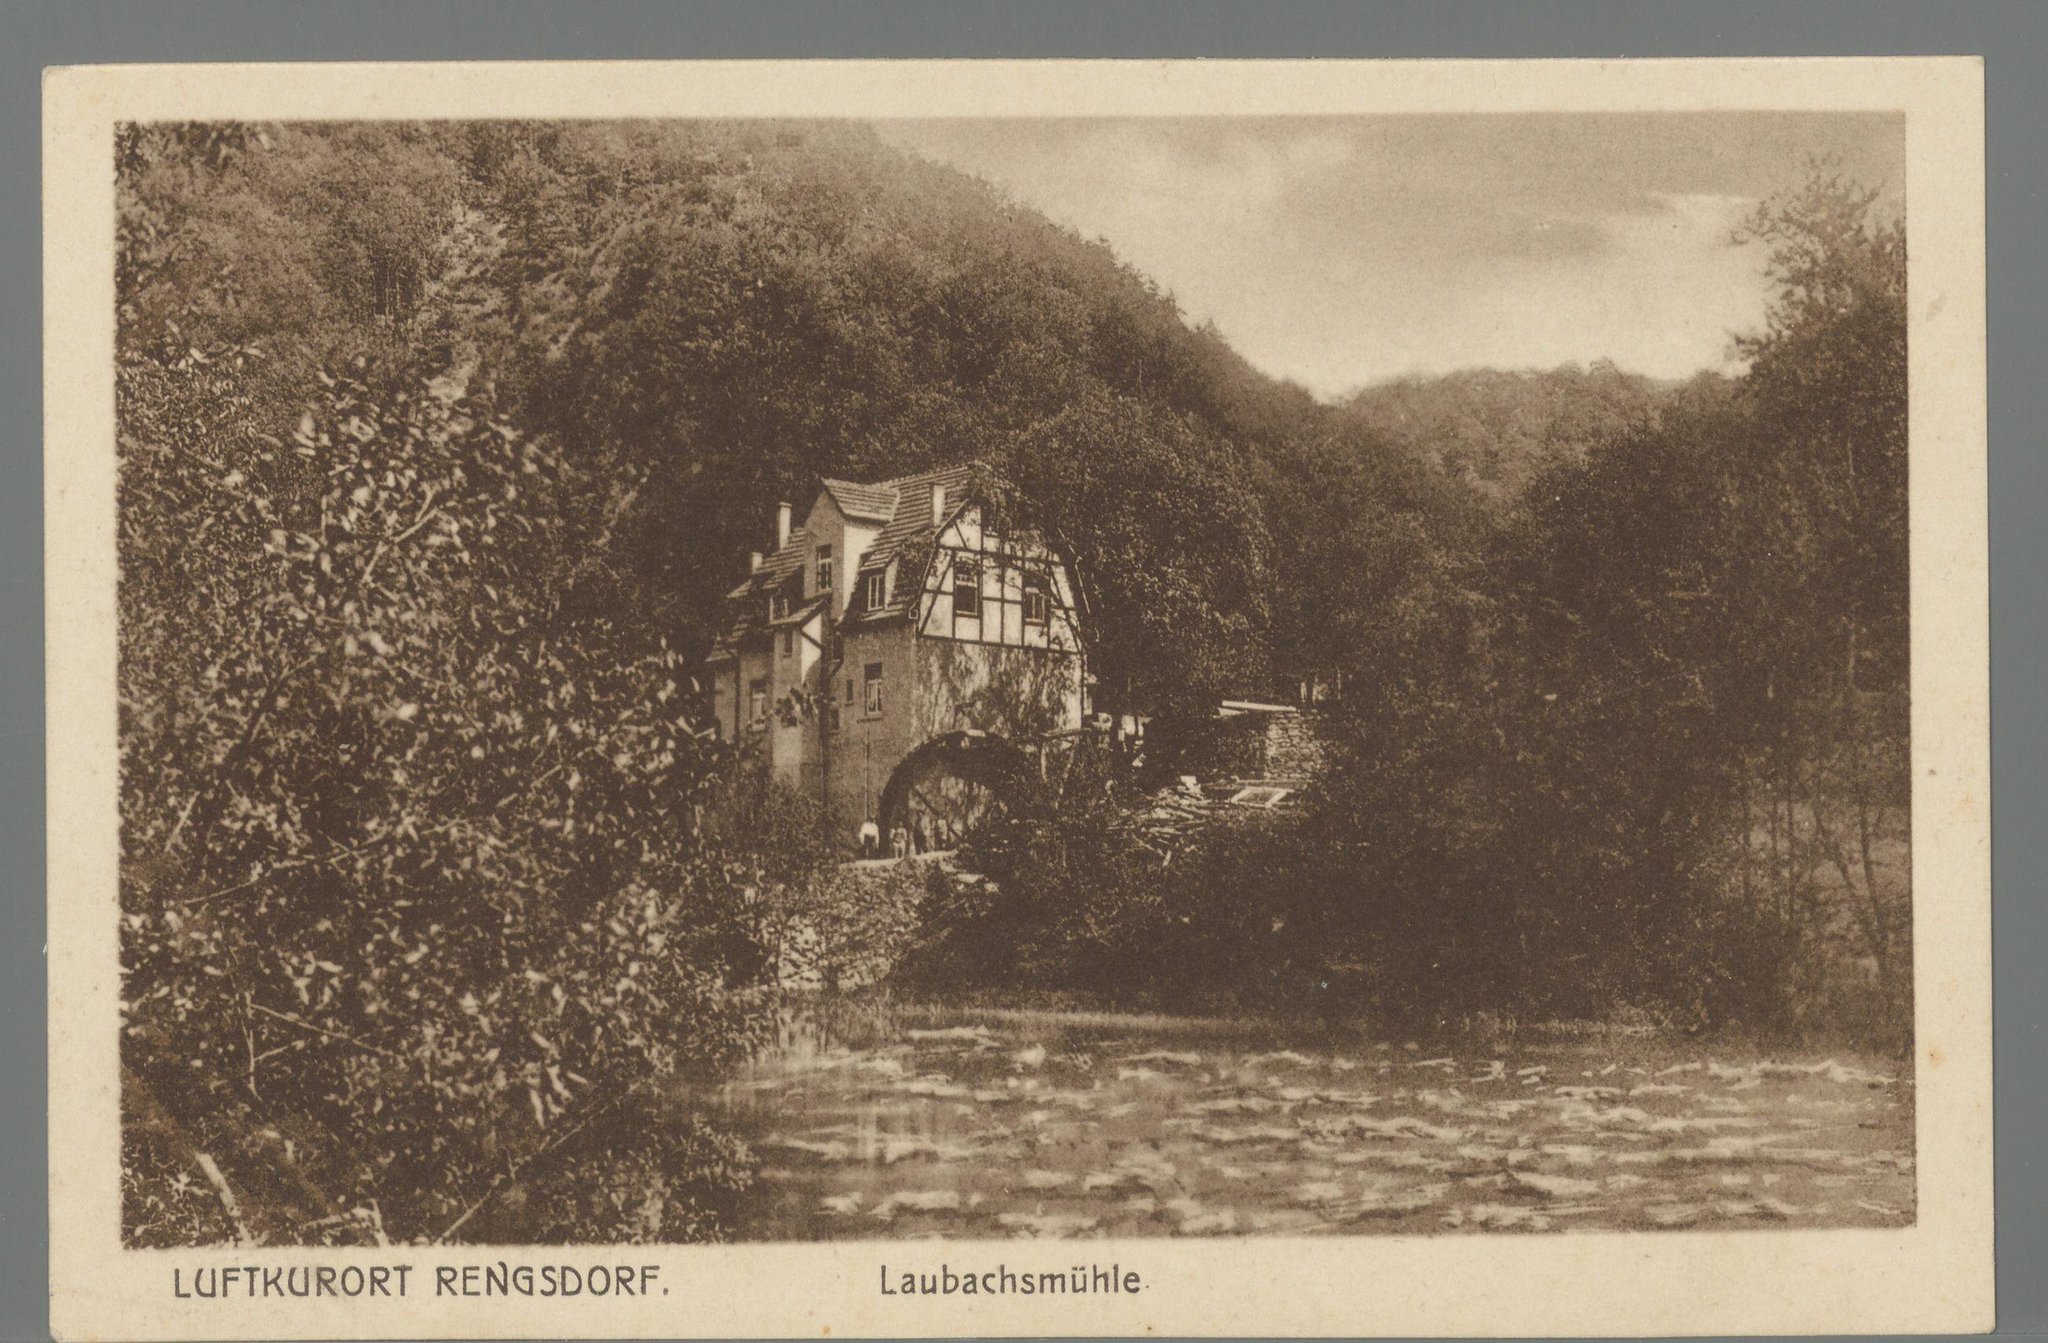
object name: ansichtkaart, prentbriefkaart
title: Luftkurort Rengsdorf. Laubachsmühle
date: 1905-1930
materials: cardboard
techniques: photograph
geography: rengsdorf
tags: river, watermill in landscape, mountains